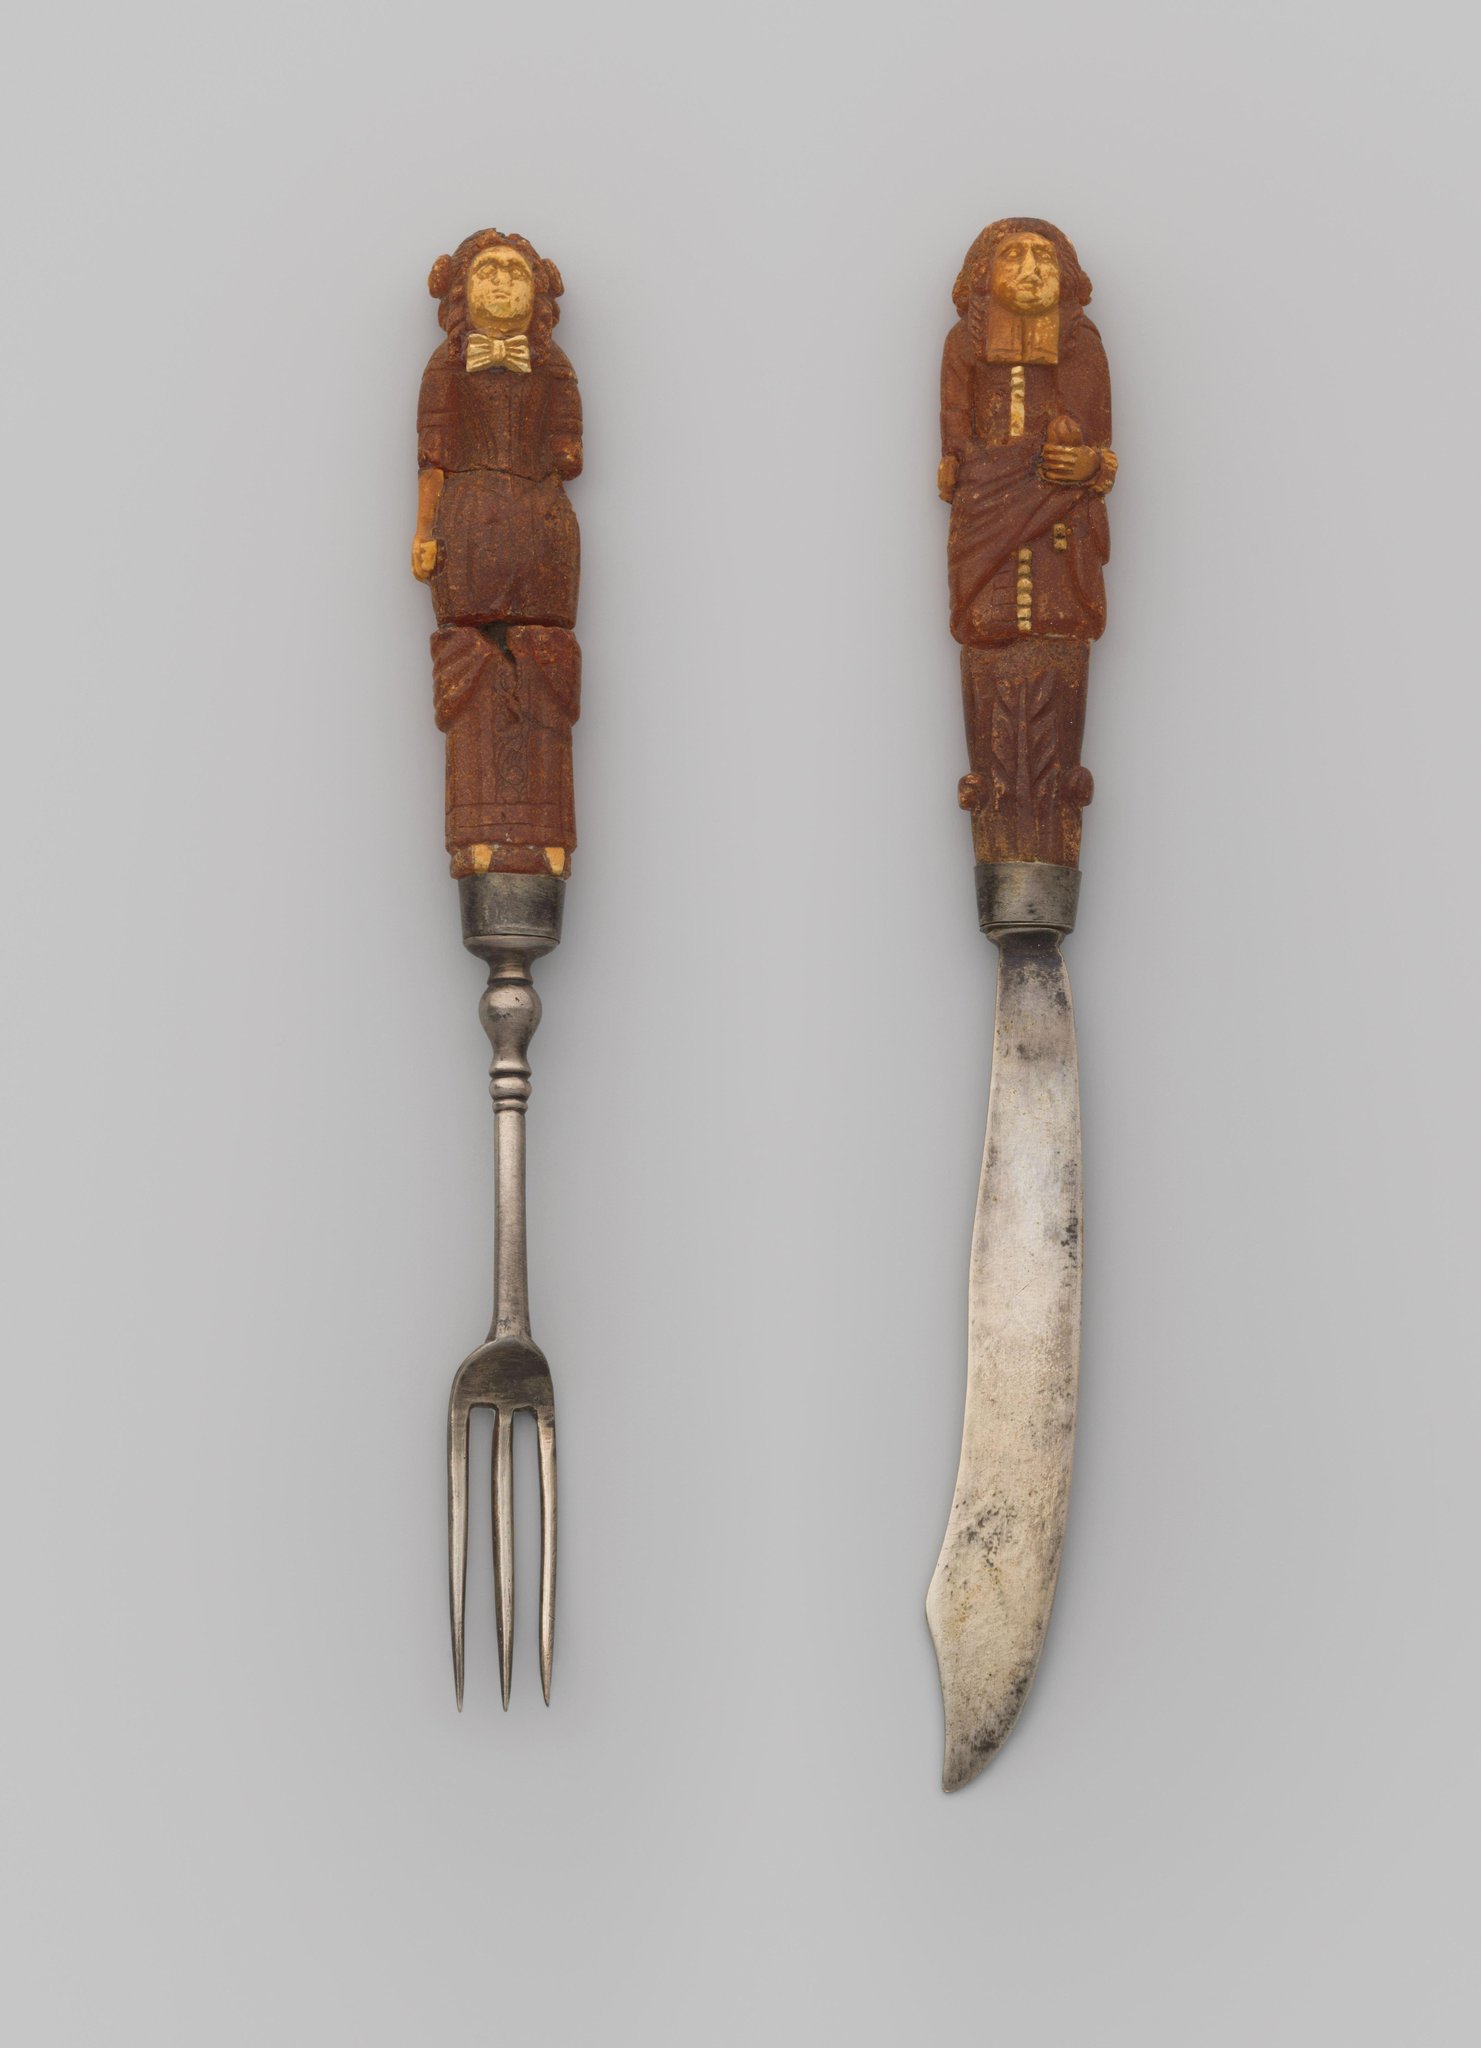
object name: knife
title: Mes met gesneden heft in de vorm van een edelman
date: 1600-1699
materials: amber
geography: germany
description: Mes met een gesneden heft van barnsteen, voorstellende een edelman. Behoort bij BK-NM-568.